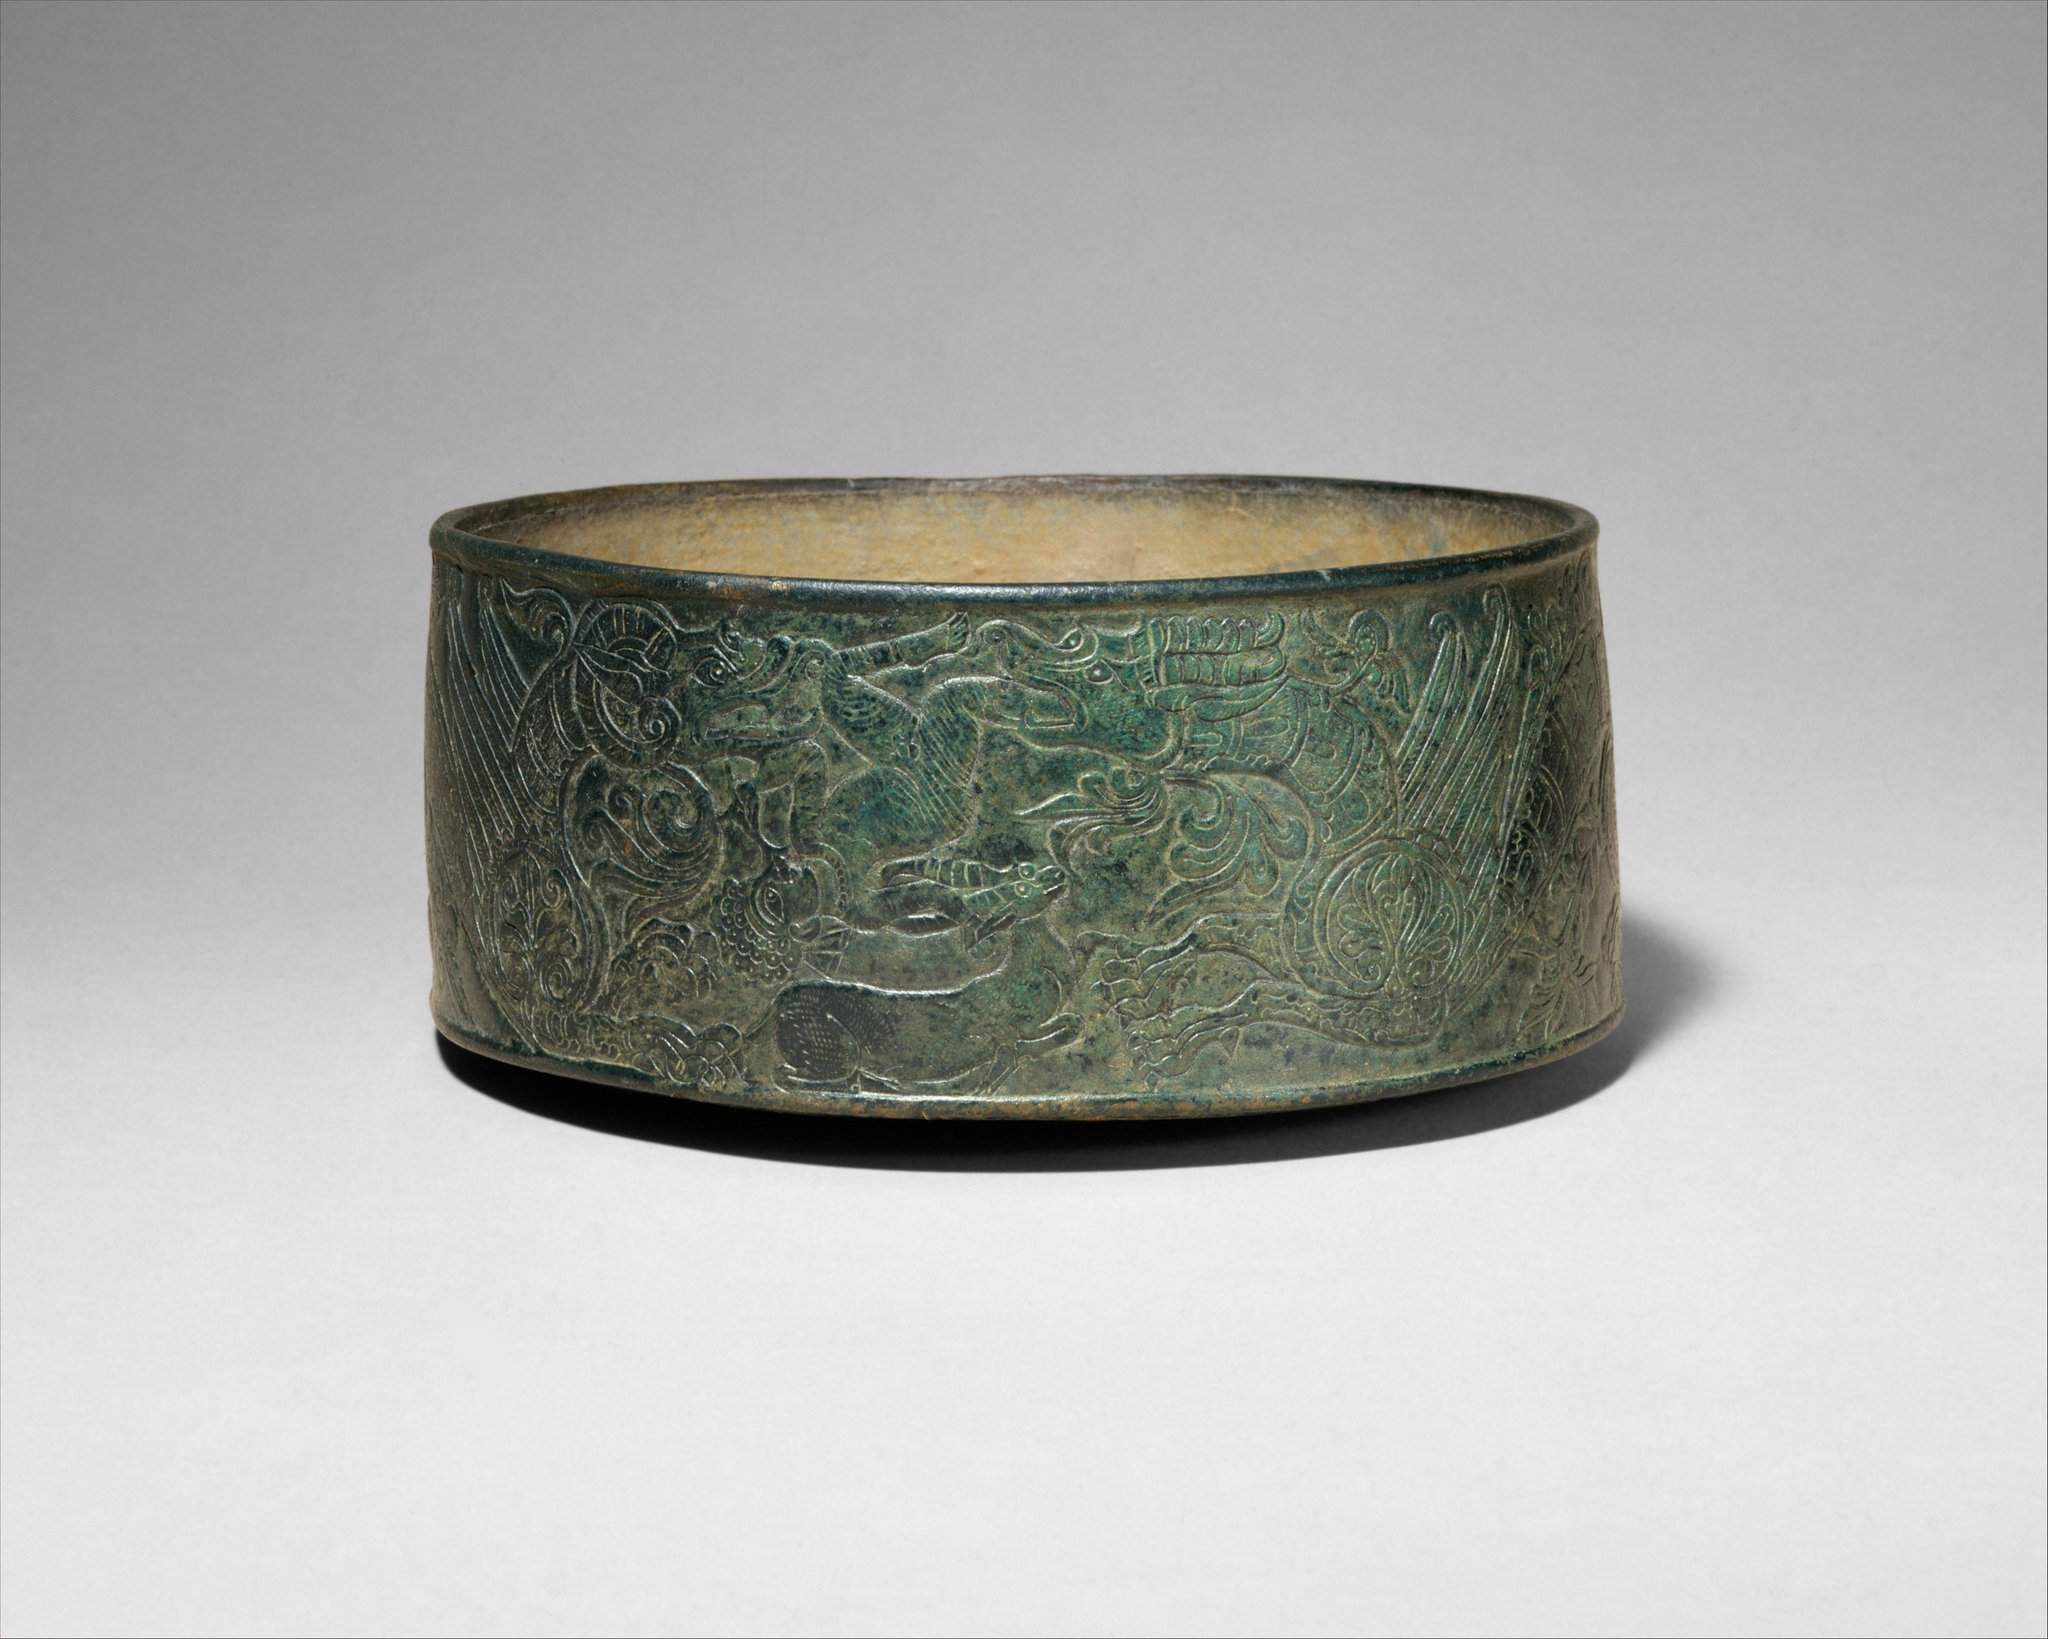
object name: basin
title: Ritual Basin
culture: afghan or central asian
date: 501-800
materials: bronze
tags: gandhara,boys,dragons